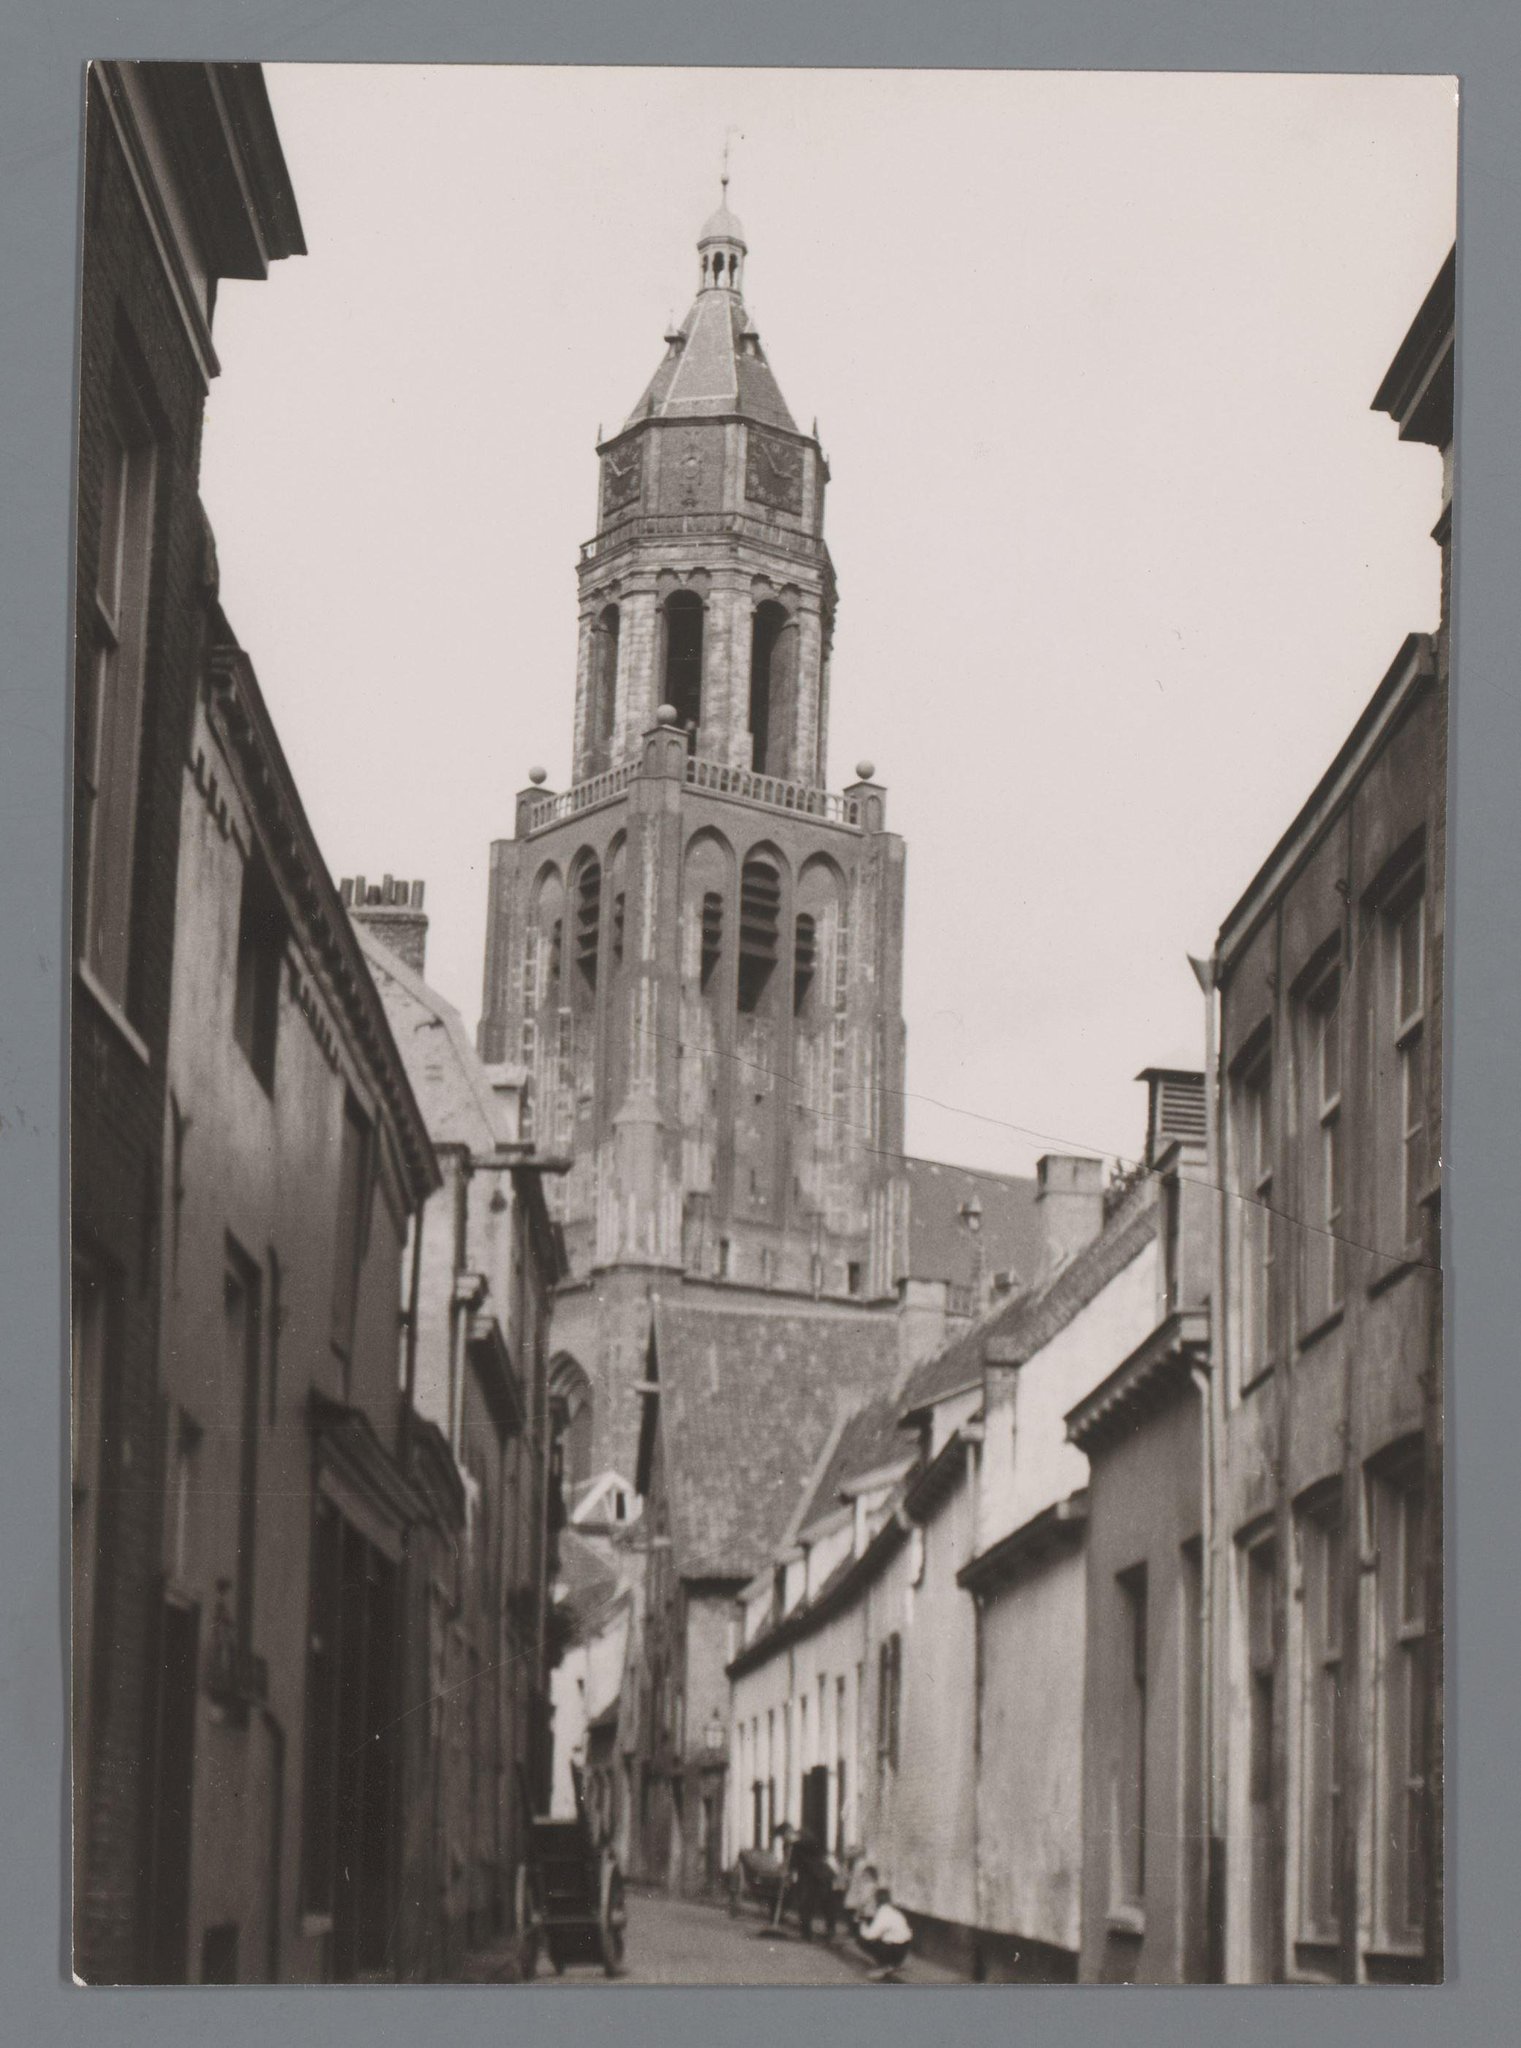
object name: photograph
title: Eusebiuskerk te Arnhem vóór de slag om Arnhem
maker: Anonymous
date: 1940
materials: paper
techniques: photography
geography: arnhem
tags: tweede wereldoorlog, slag om arnhem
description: Eusebiuskerk te Arnhem vóór de slag om Arnhem.